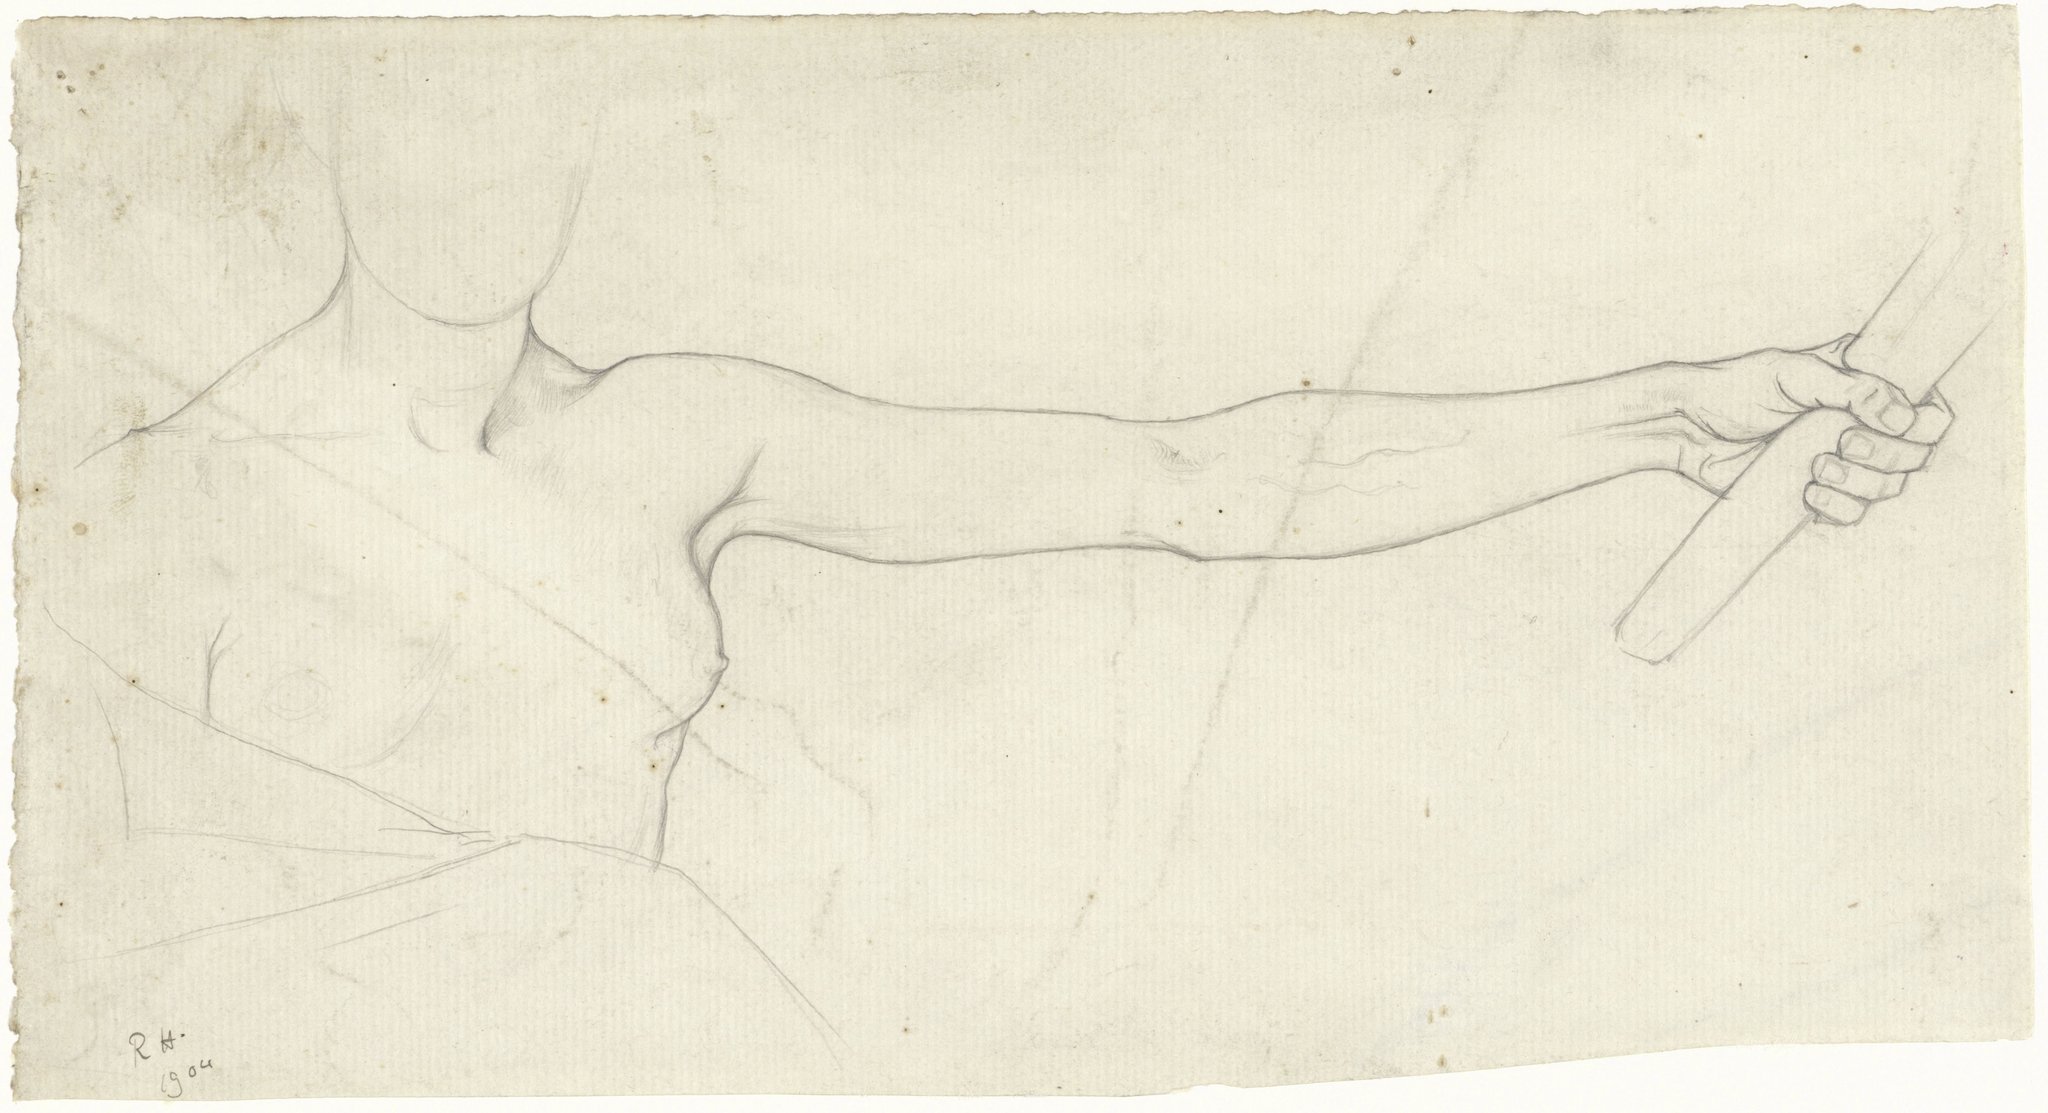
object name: drawing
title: Rechterarm en bovenlichaam van een vrouw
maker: richard nicolaüs roland holst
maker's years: 1868-1938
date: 1904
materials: paper, pencil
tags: breasts, arms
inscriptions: date: ‘1904’